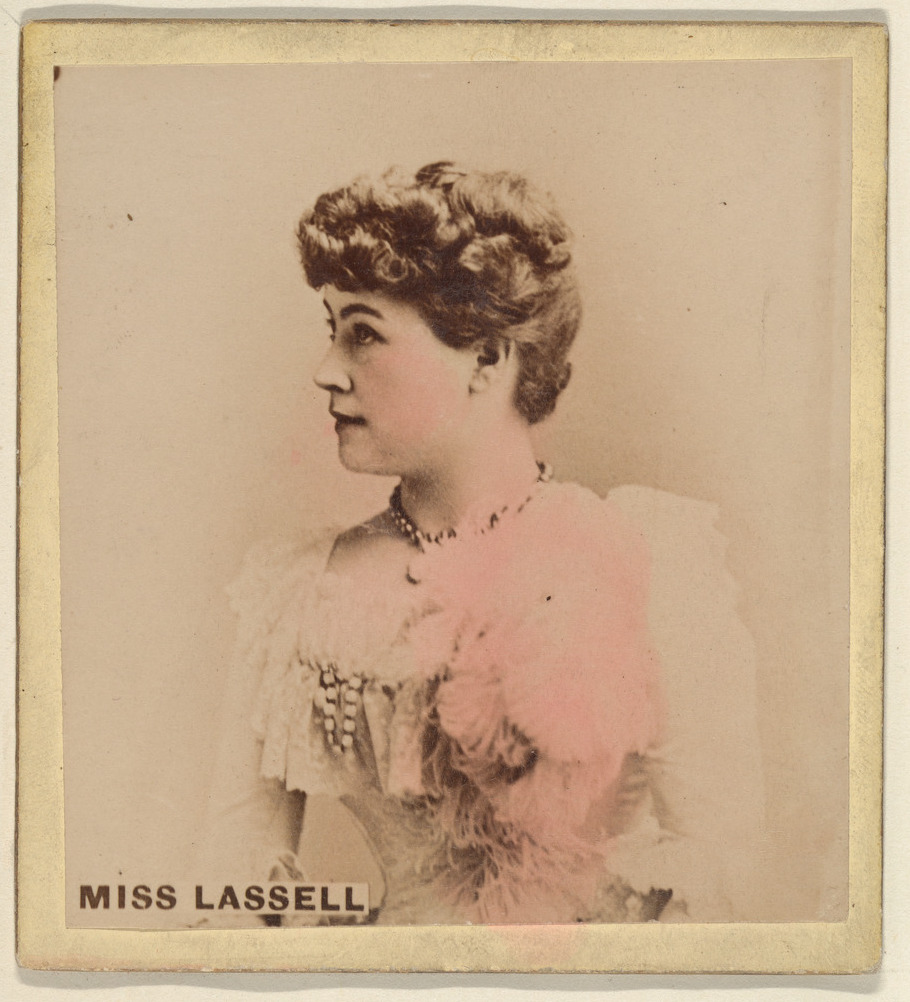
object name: photograph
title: Miss Lassell, from the Actresses series (N246), Type 2, issued by Kinney Brothers to promote Sporting Extra Cigarettes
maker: kinney brothers tobacco company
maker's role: publisher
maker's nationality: american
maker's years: 1869-2011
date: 1890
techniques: albumen silver print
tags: women,actresses